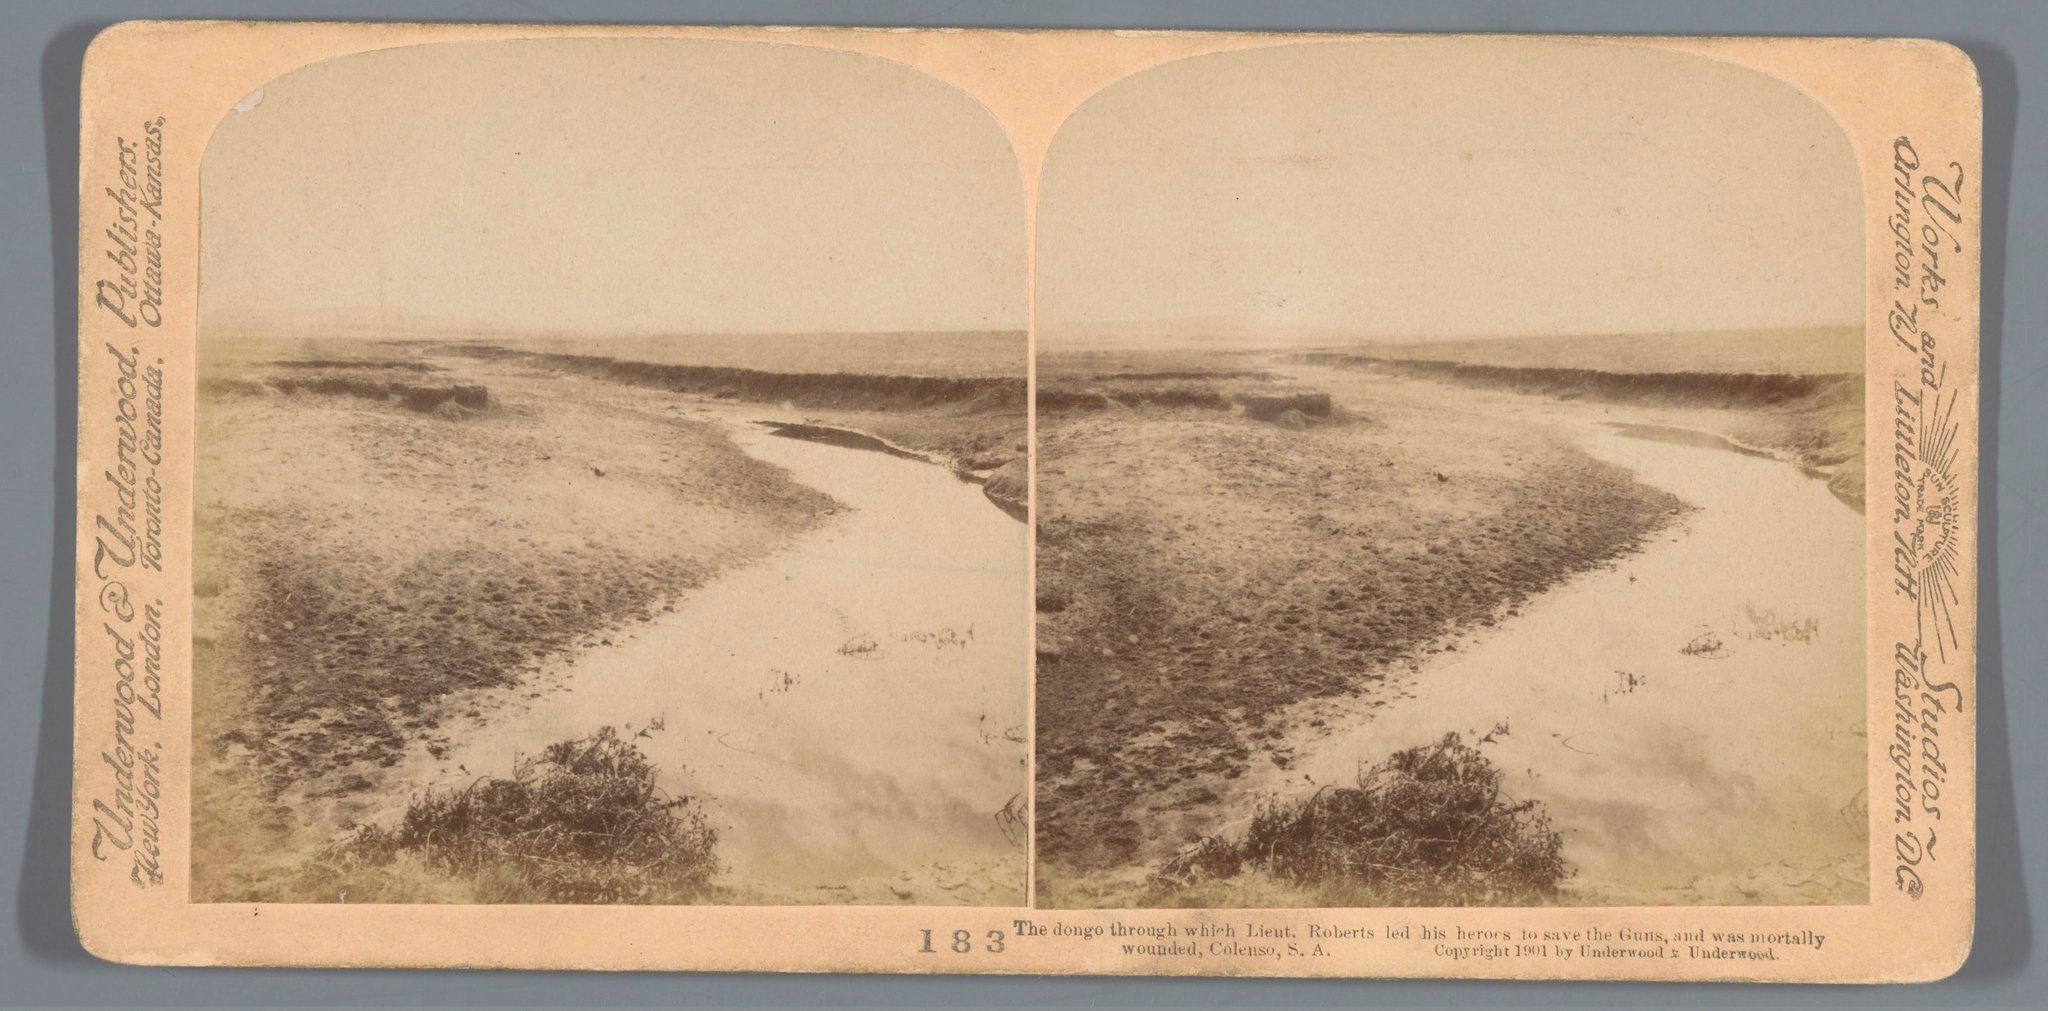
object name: stereograph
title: The dongo, through which Lieut. Roberts led his heroes to save the Guns, and was mortally wounded, Colenso, S.A.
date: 1901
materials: cardboard, photographic support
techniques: albumen print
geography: colenso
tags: landscapes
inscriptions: name: ‘Works and Studios Sun Sculpture trade mark Arlington N.J. Littleton N.H. Washington D.C.’, number: ‘183’